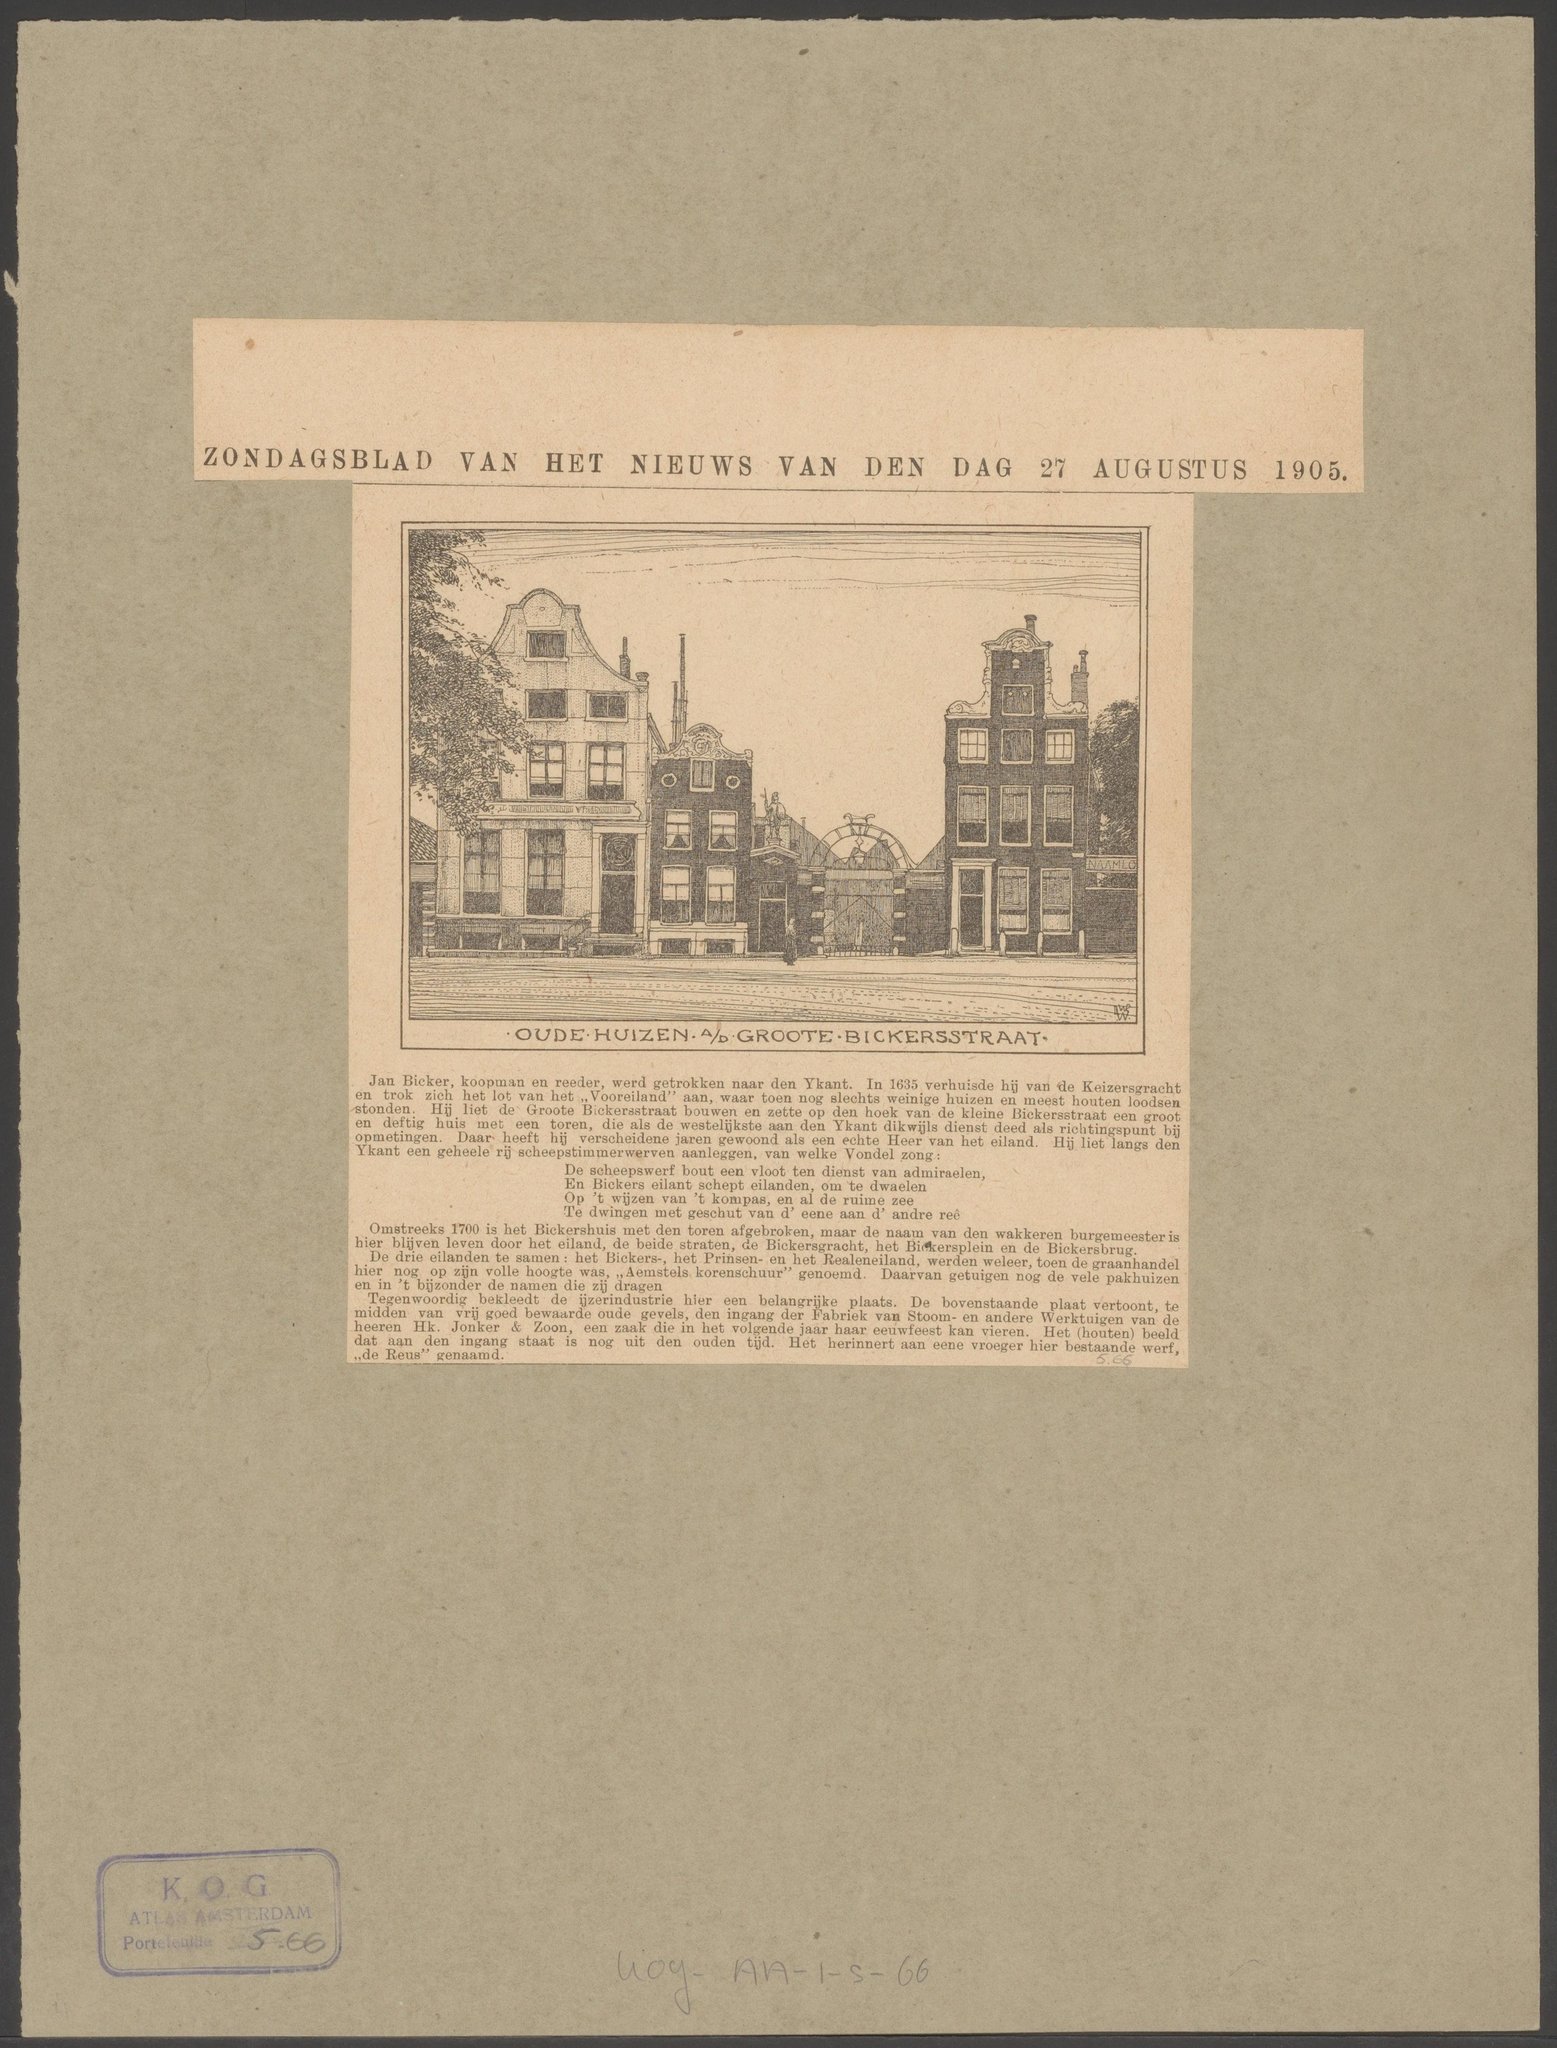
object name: photomechanical print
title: Gezicht op enkele huizen aan de Grote Bickersstraat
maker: willem wenckebach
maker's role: designer, draughtsman, painter, print maker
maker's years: 1860-1937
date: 1905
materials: paper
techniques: letterpress printing, line block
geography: amsterdam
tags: city-view in general; 'veduta', the usual house or row of houses, façade (of house or building), street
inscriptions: collector's mark: ‘5.66’ Lugt 1641b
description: Onderwerpsrubriek binnen de Atlas Amsterdam: Begijnensloot (Gedempte), Bagijnhofsteeg, Beulingsloot, Bickersgracht en –plein, Bickersstraat (Groote), Bilderdijkskade en -straat, Binnenkant, Blauwburgwal, Boomdwarsstraat, Brouwersgracht, Bleekersspad (Lange), Bleekerssloot, Bloemgracht, Boerenwetering, Boltensgrachtje, Boomssloot (Recht), Badhuisweg.